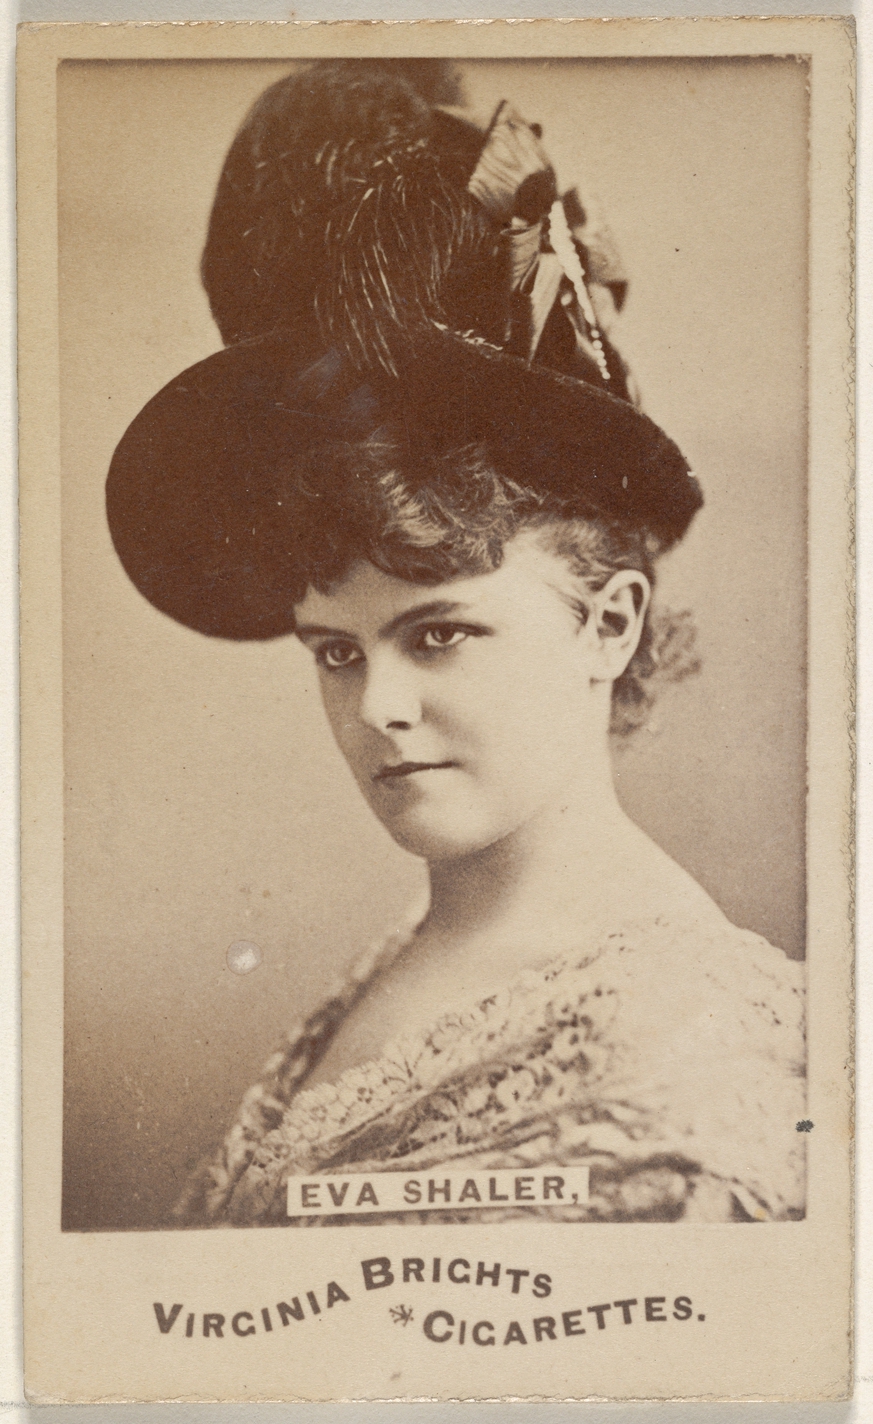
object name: photograph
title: Eva Shaler, from the Actors and Actresses series (N45, Type 6) for Virginia Brights Cigarettes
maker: allen & ginter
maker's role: publisher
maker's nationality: american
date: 1888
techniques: albumen silver print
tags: portraits,women,actresses